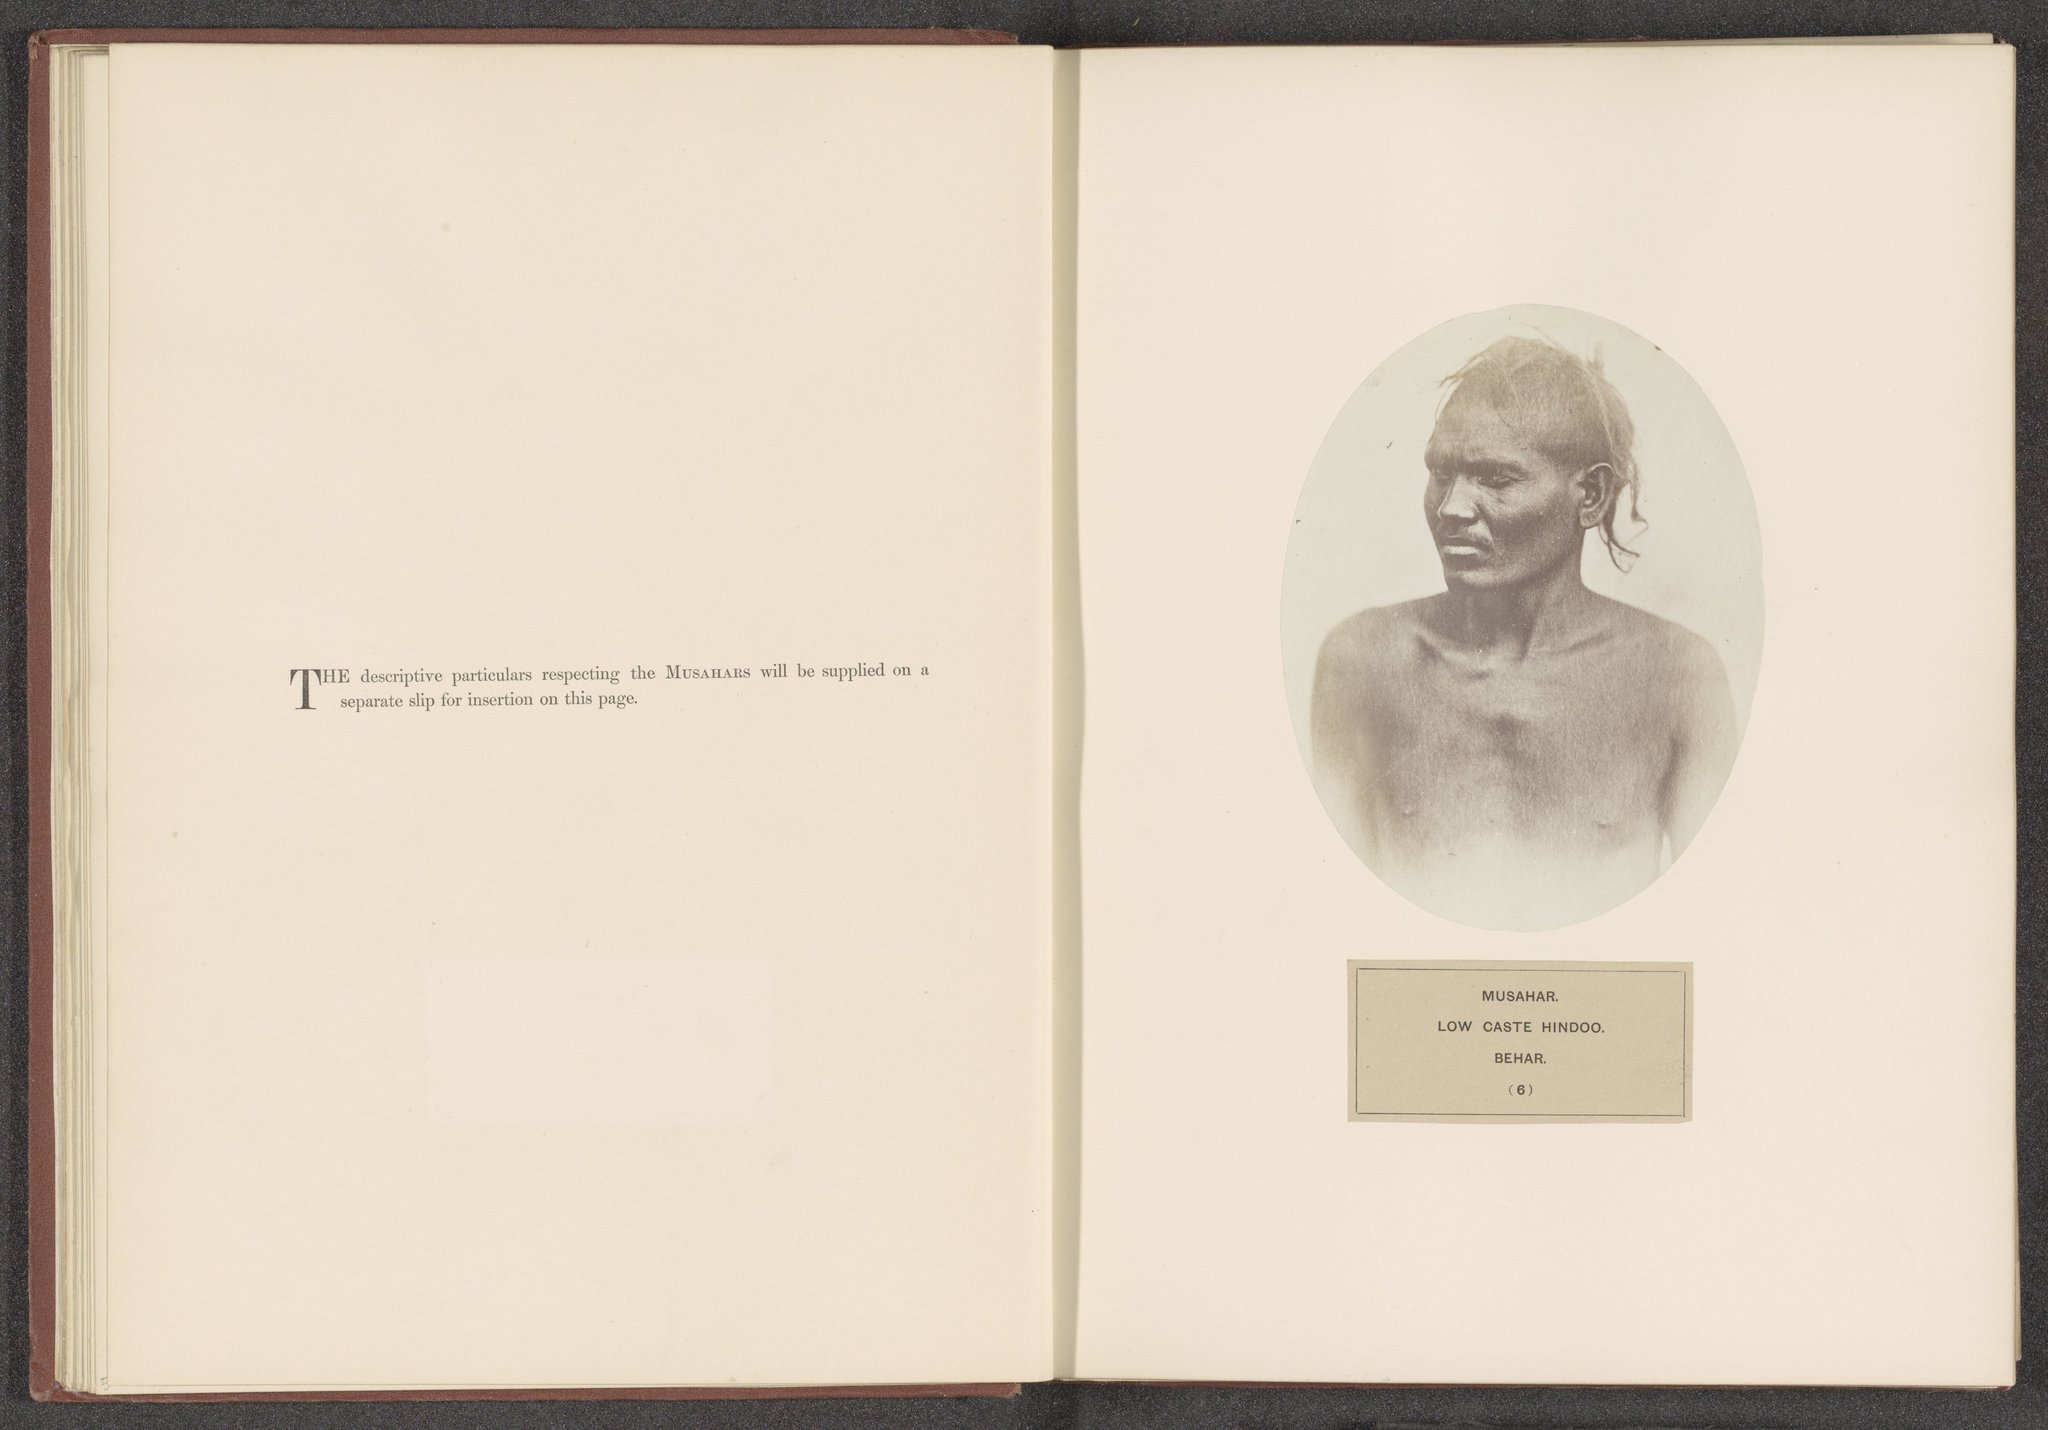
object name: photograph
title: Portrait of an unknown man from the Musahar community of Bihar in eastern India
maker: Anonymous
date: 1858-1868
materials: photographic support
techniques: albumen print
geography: bihar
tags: human races; peoples; nationalities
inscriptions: inscription: ‘MUSAHAR./ LOW CASTE HINDOO./ BEHAR.’, number: ‘(6)’